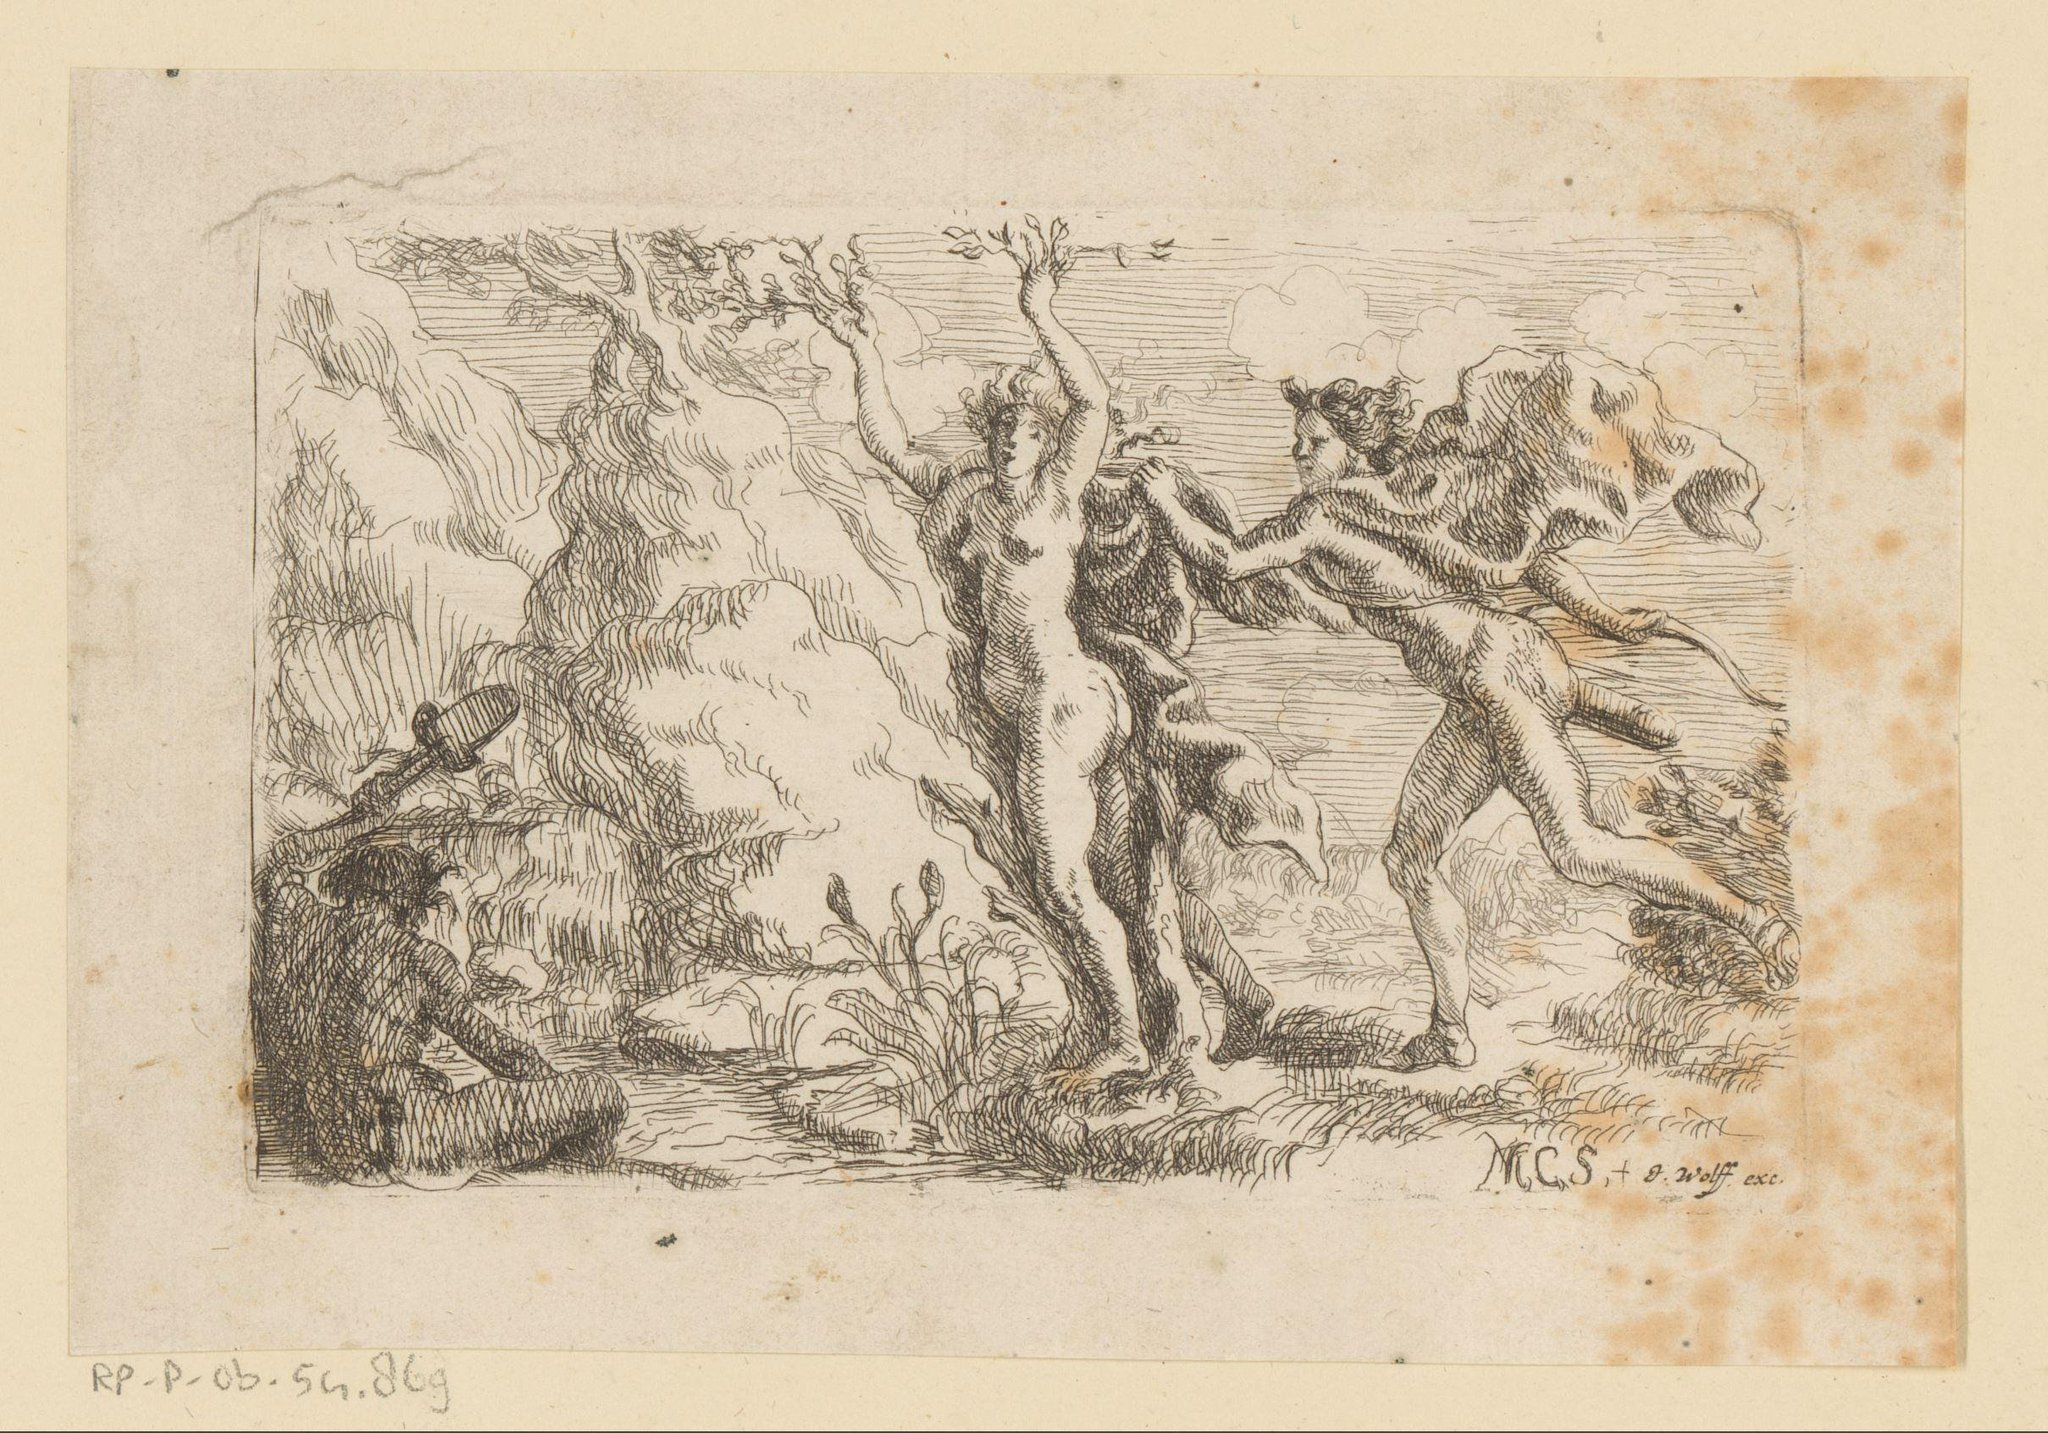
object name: print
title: Loves of the Gods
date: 1686-1704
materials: paper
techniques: etching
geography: augsburg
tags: daphne changed into a laurel-tree: while fleeing from apollo, daphne is changed into a laurel-tree by her father peneus (ovid, metamorphoses i 548)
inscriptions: collector's mark: Lugt 240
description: Prent maakt deel uit van een serie bestaande uit ten minste vier prenten met mythologische godenliefden.